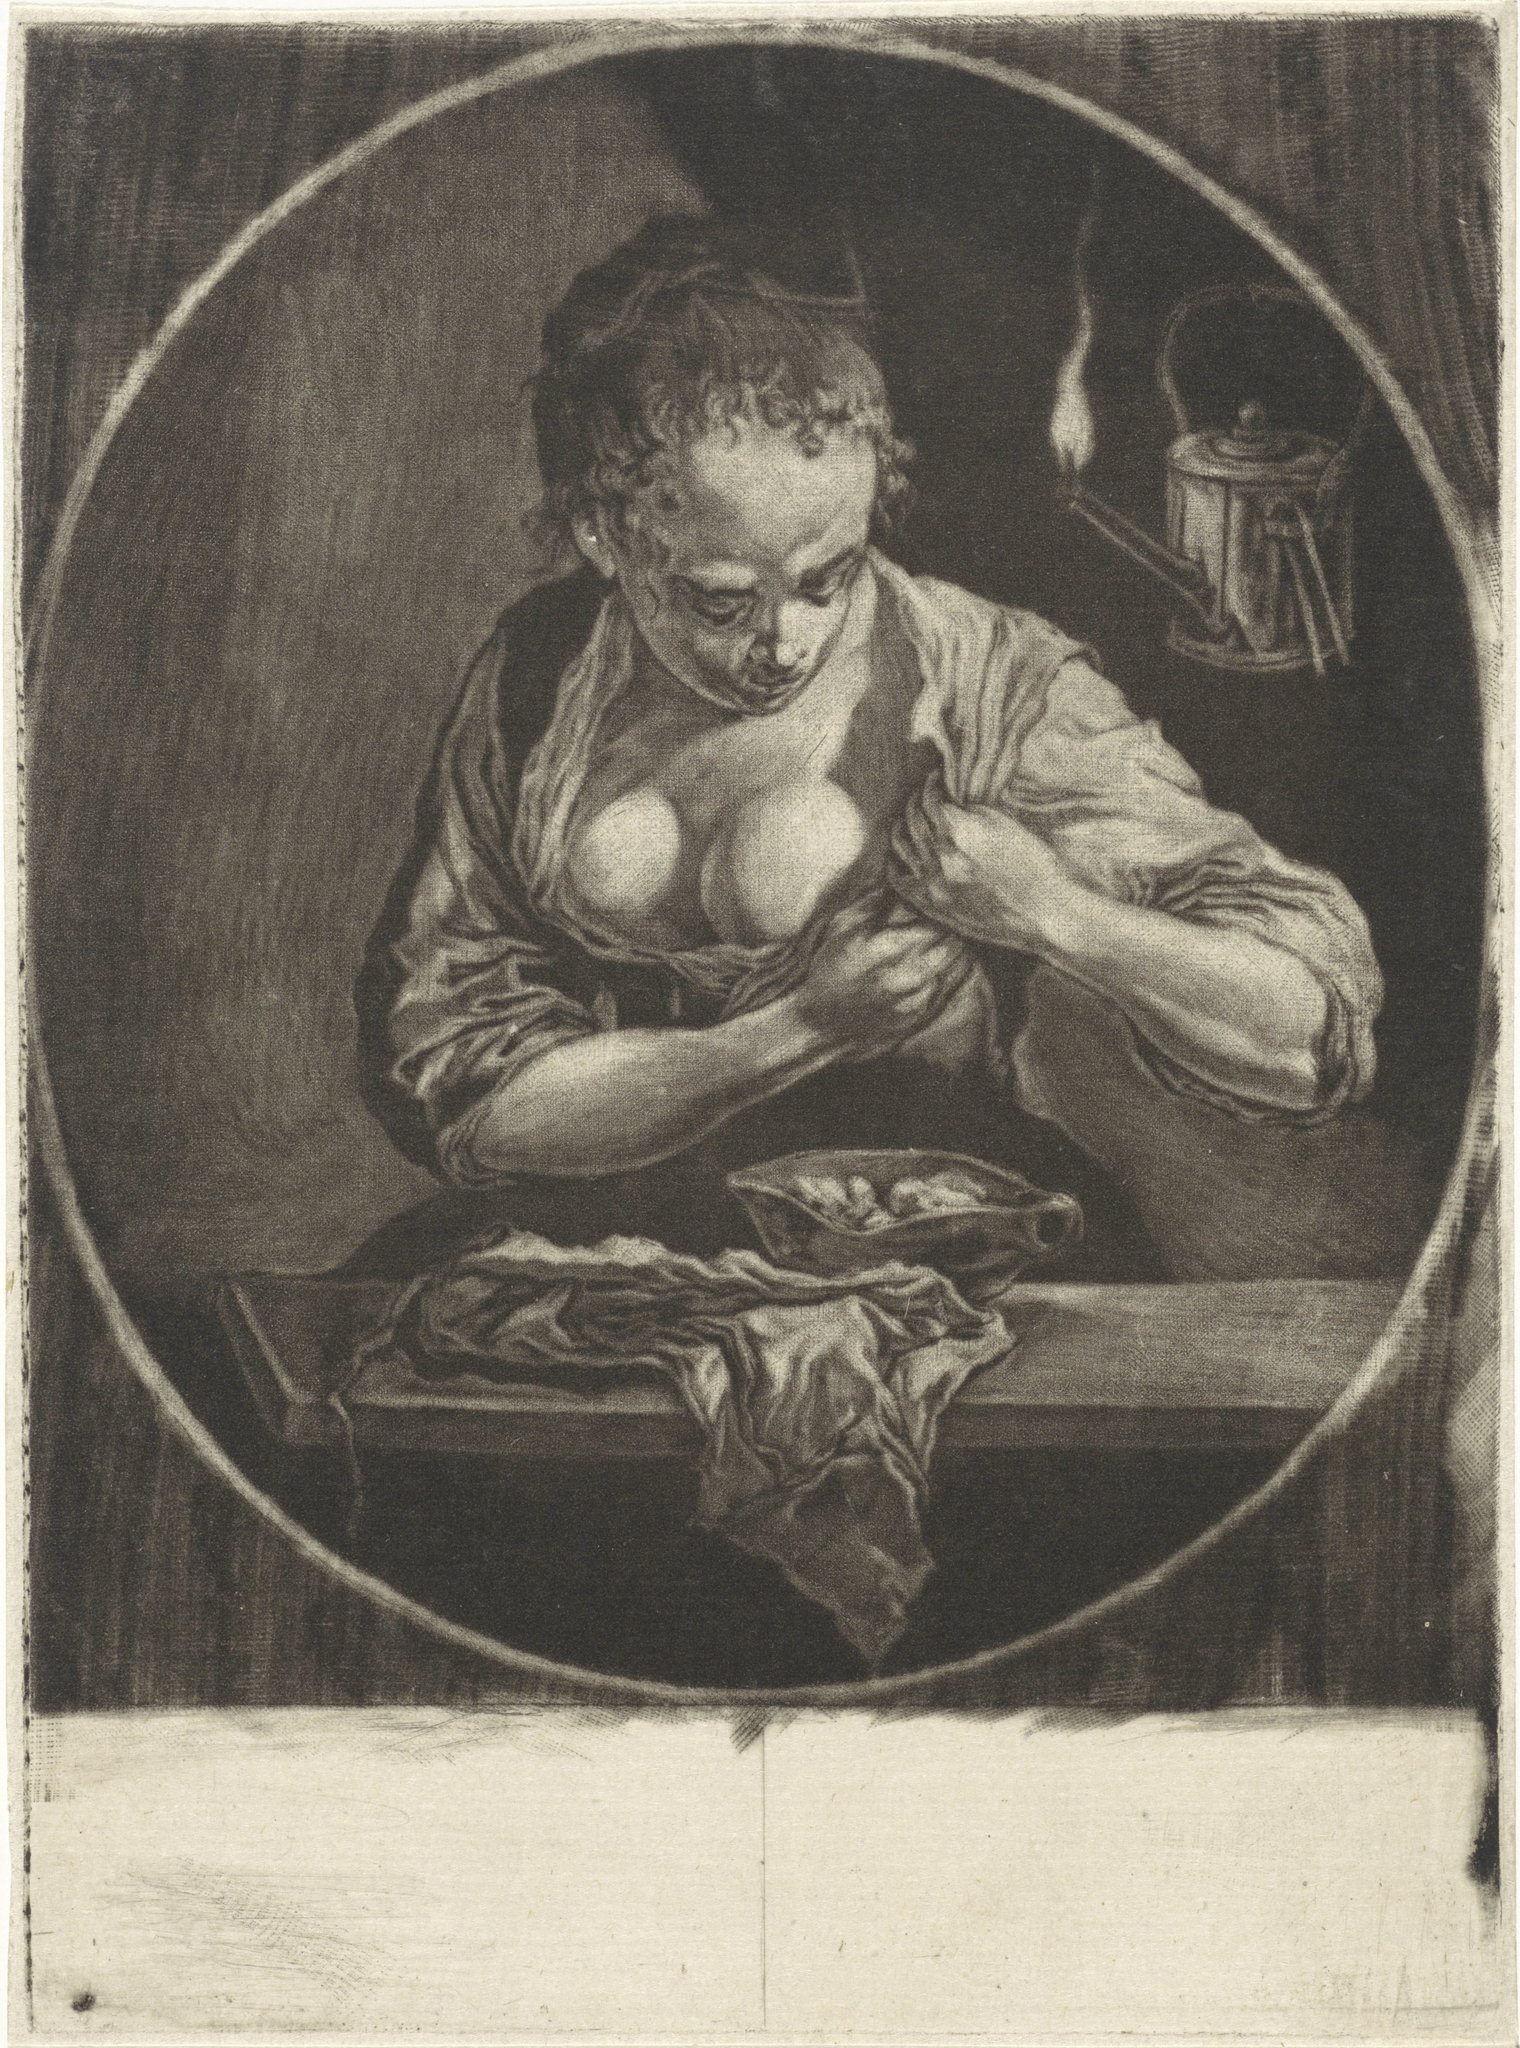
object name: print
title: Zich vlooiende vrouw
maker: cornelis dusart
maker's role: draughtsman, painter, print maker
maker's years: 1660-1704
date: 1670-1704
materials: paper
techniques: mezzotint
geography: haarlem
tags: candle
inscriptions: collector's mark: Lugt 2228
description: Bij het licht van een olielamp zoekt een jonge vrouw naar vlooien in haar kleding